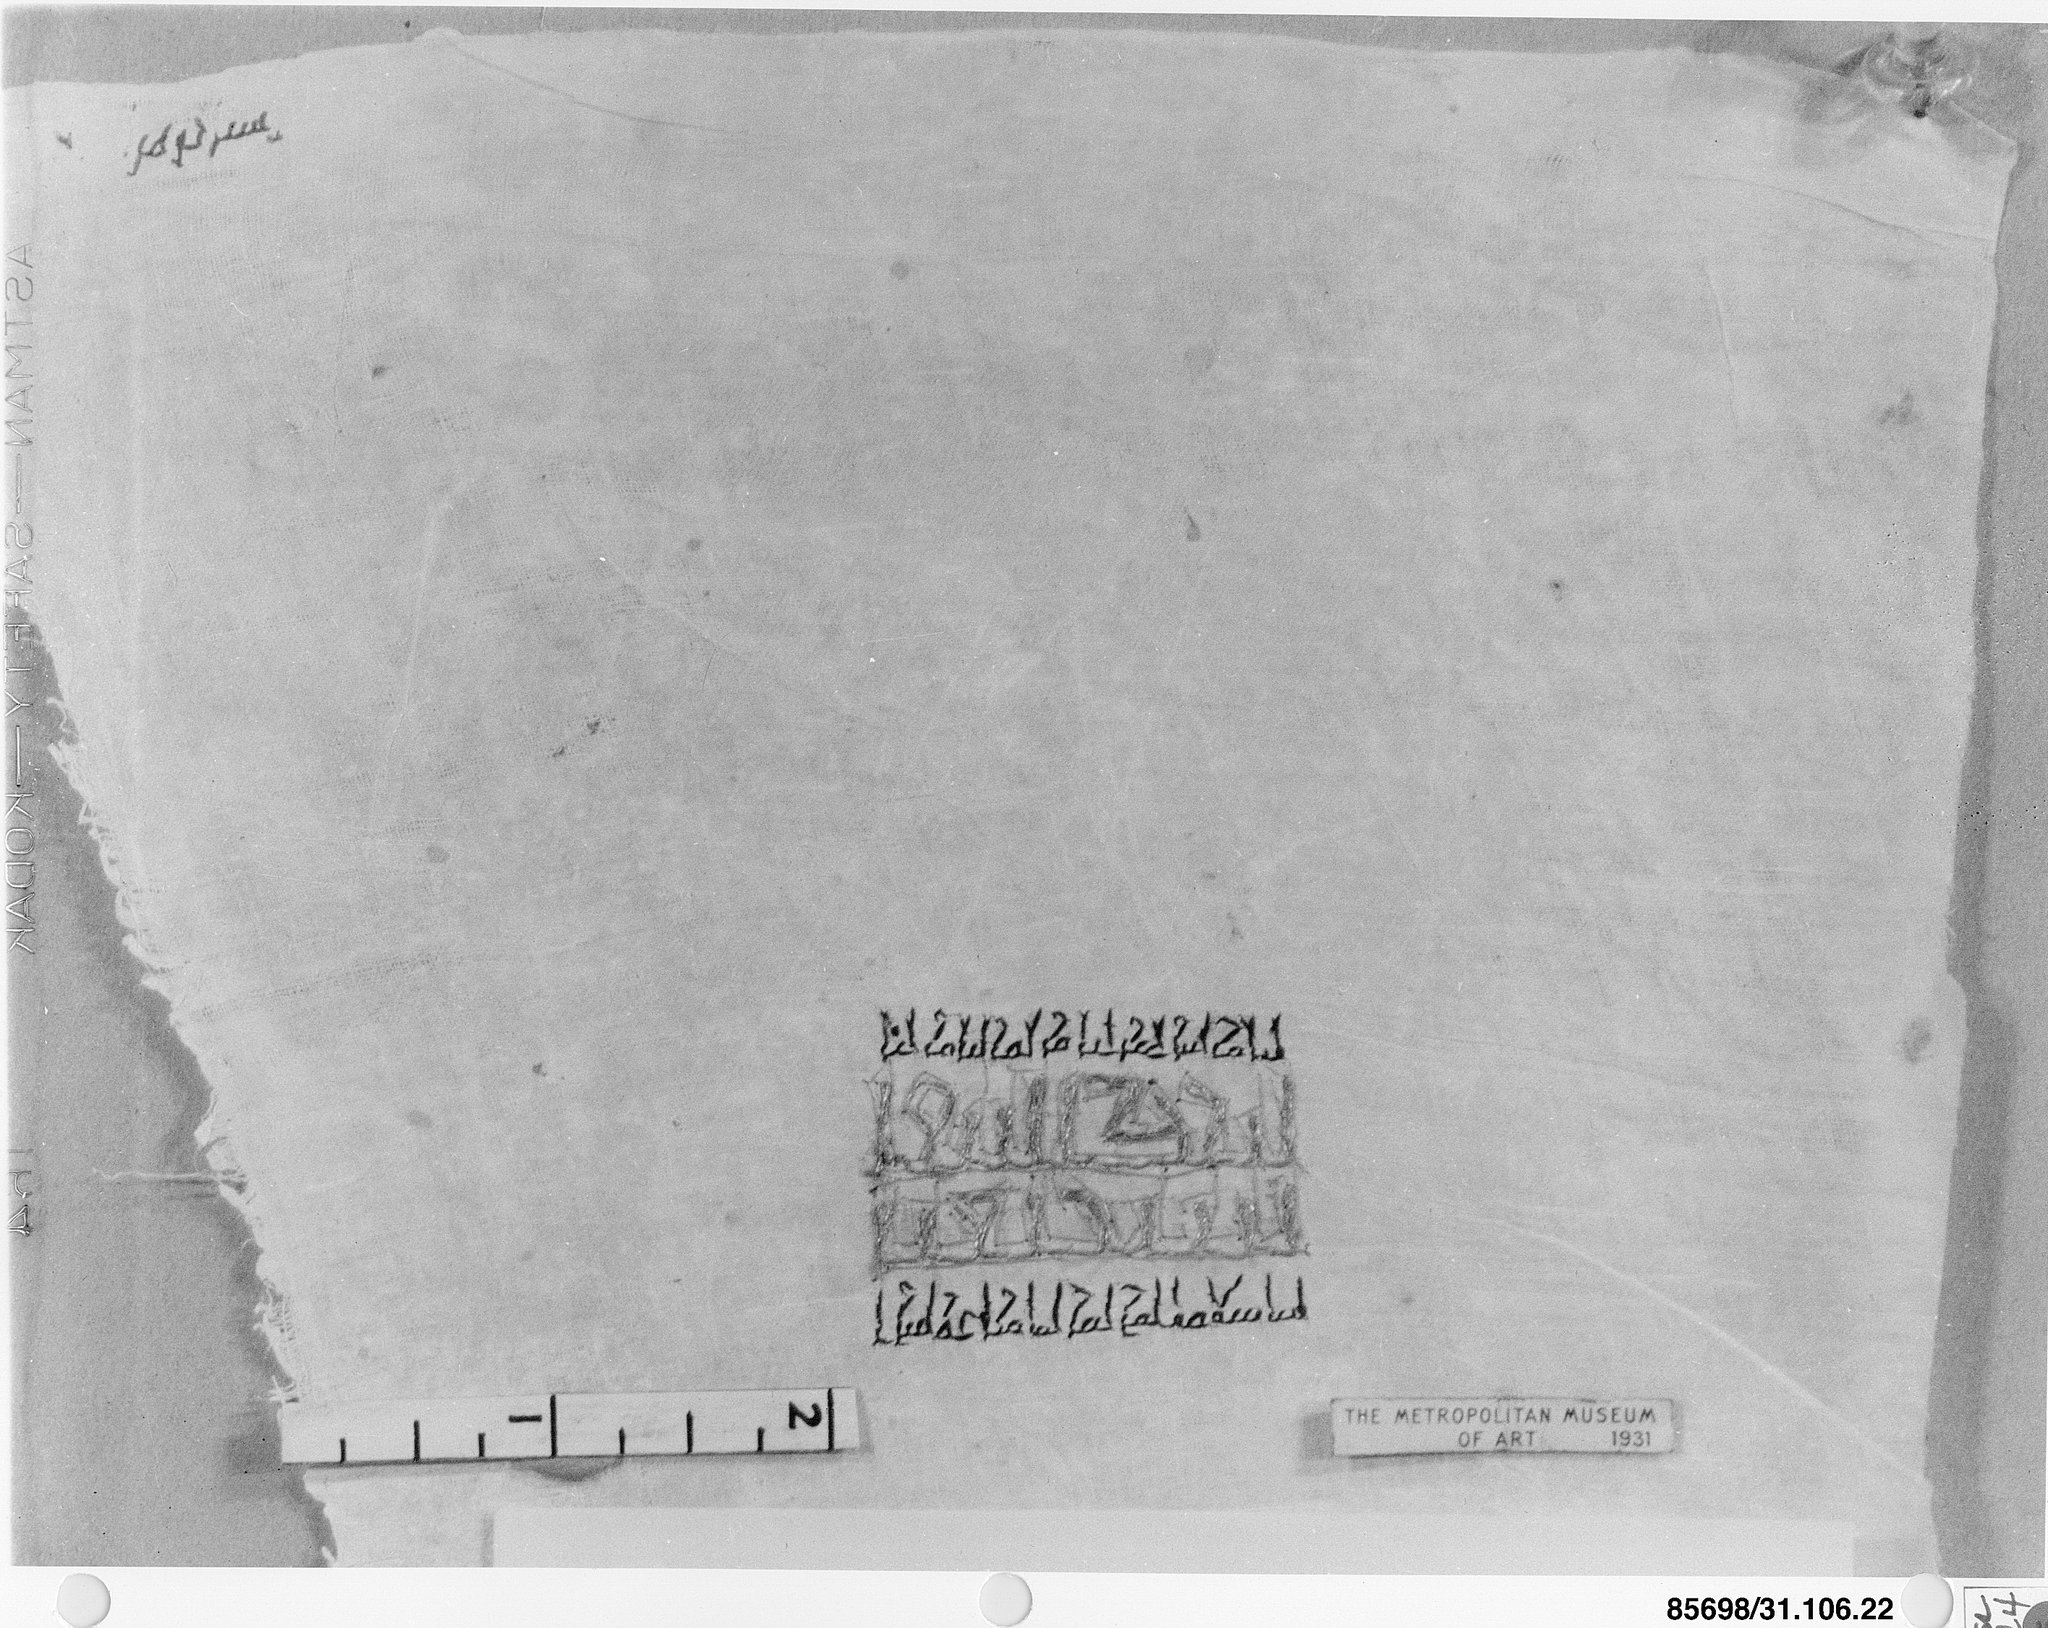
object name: textile fragment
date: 901-1000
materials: linen, metal thread, silk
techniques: embroidery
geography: egypt